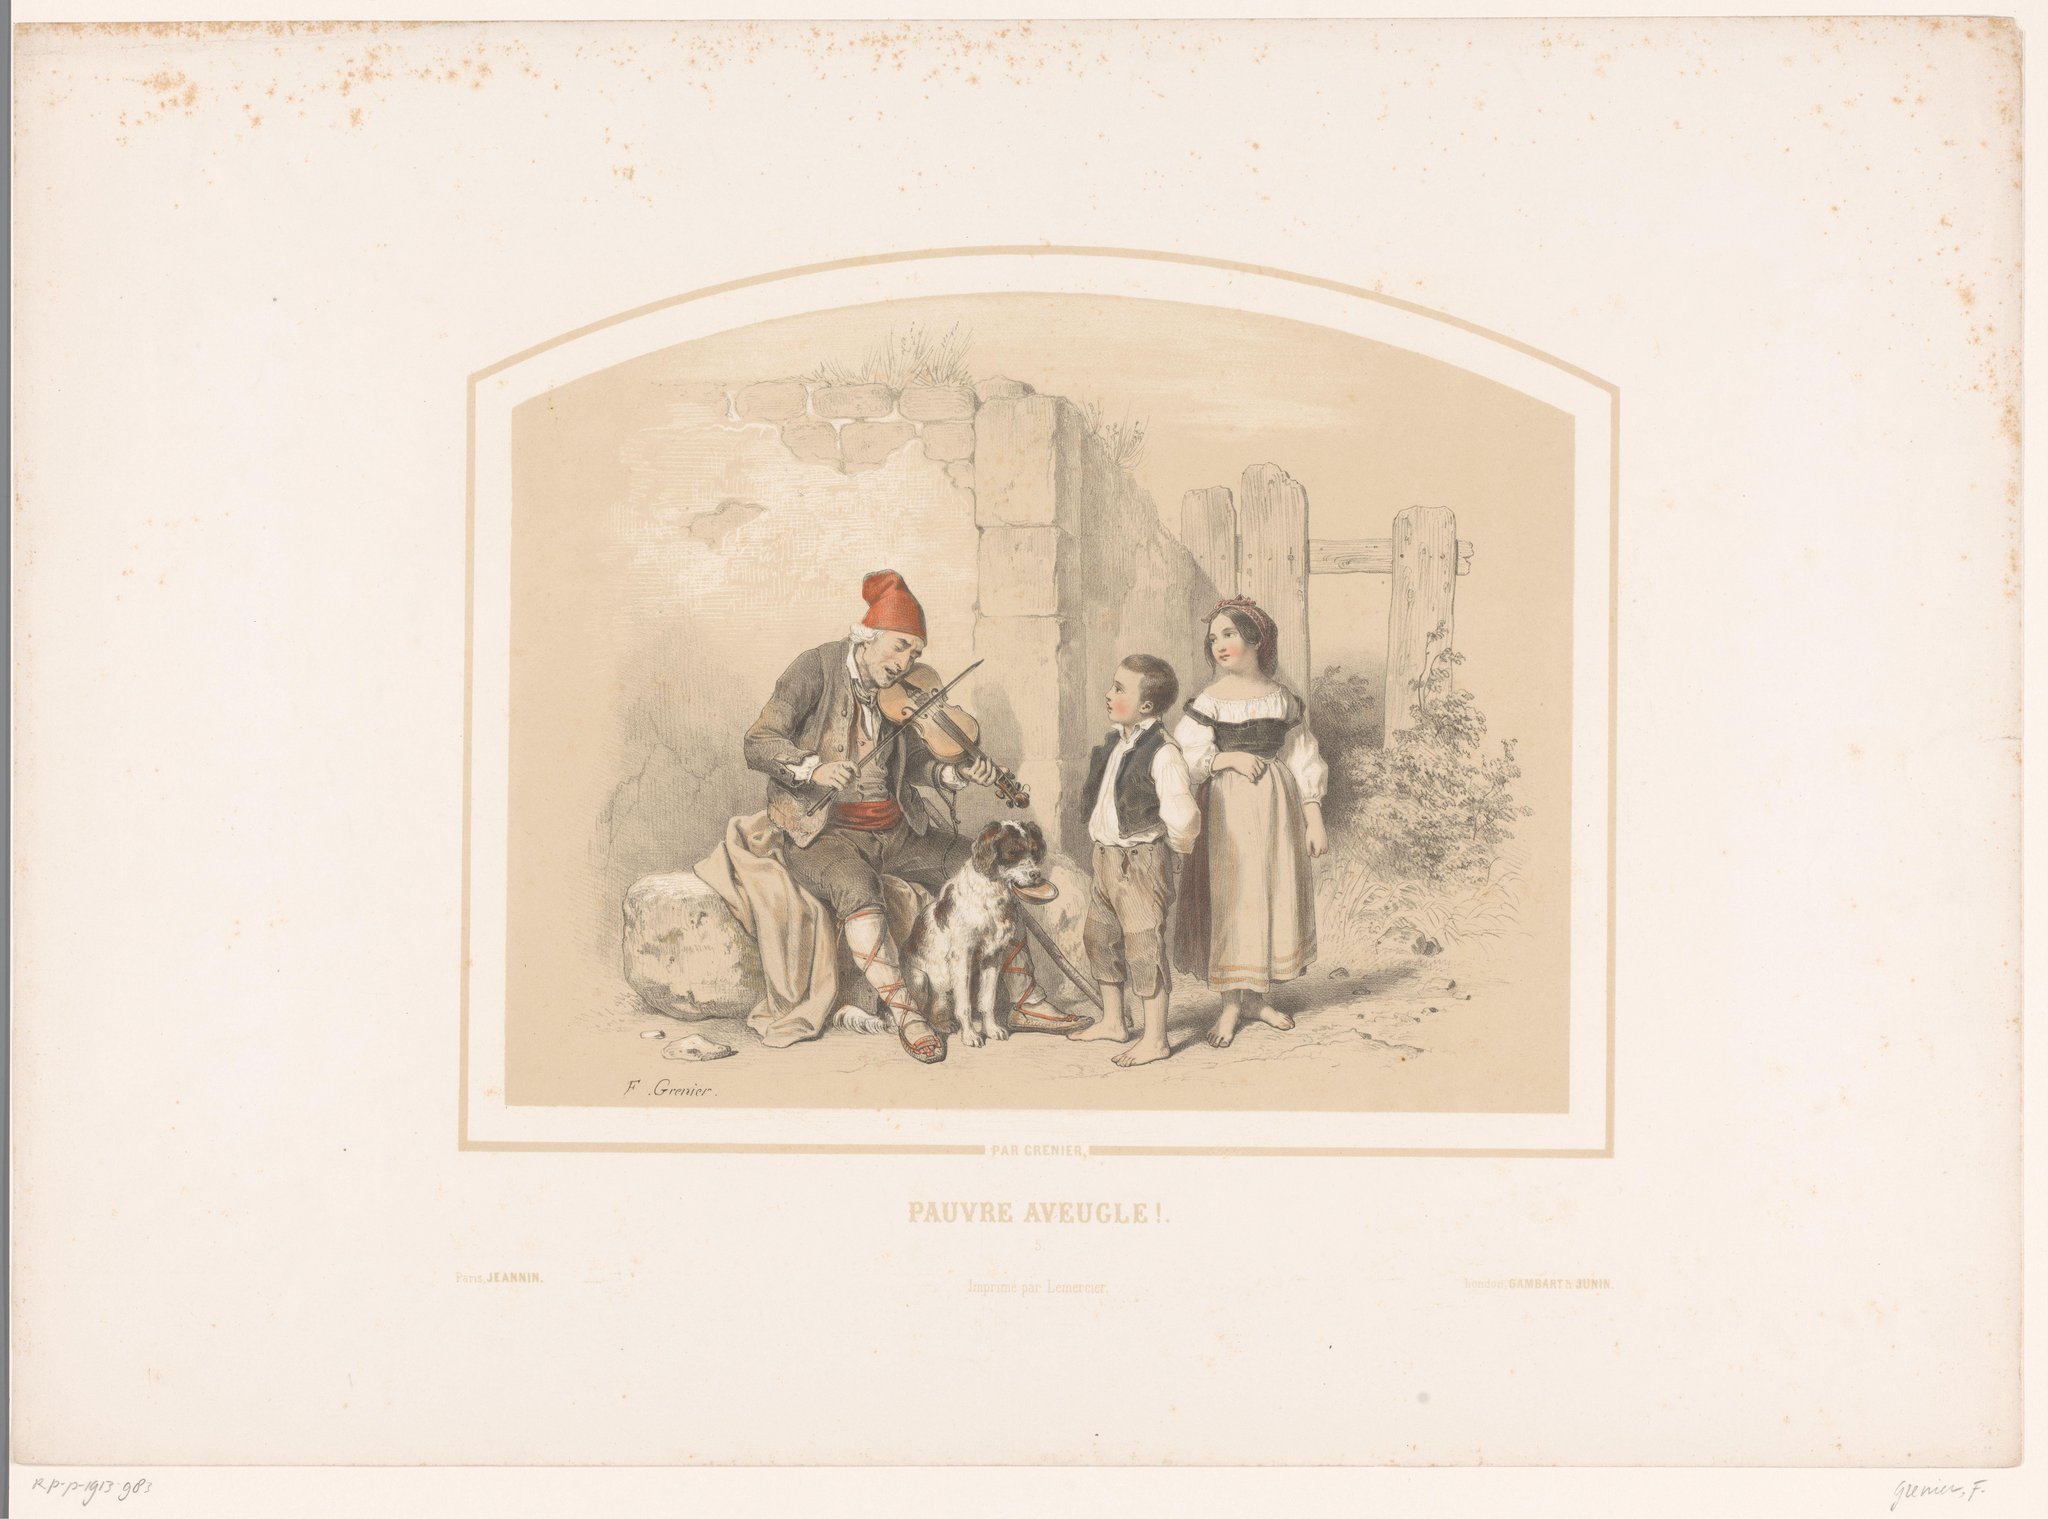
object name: print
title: Pauvre aveugle!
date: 1819-1854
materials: paper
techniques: hand coloring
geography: paris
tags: blind, blindness, violin, fiddle - cc - out of doors, begging bowl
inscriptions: check stamp: Lugt 5002, collector's mark: Lugt 2228a